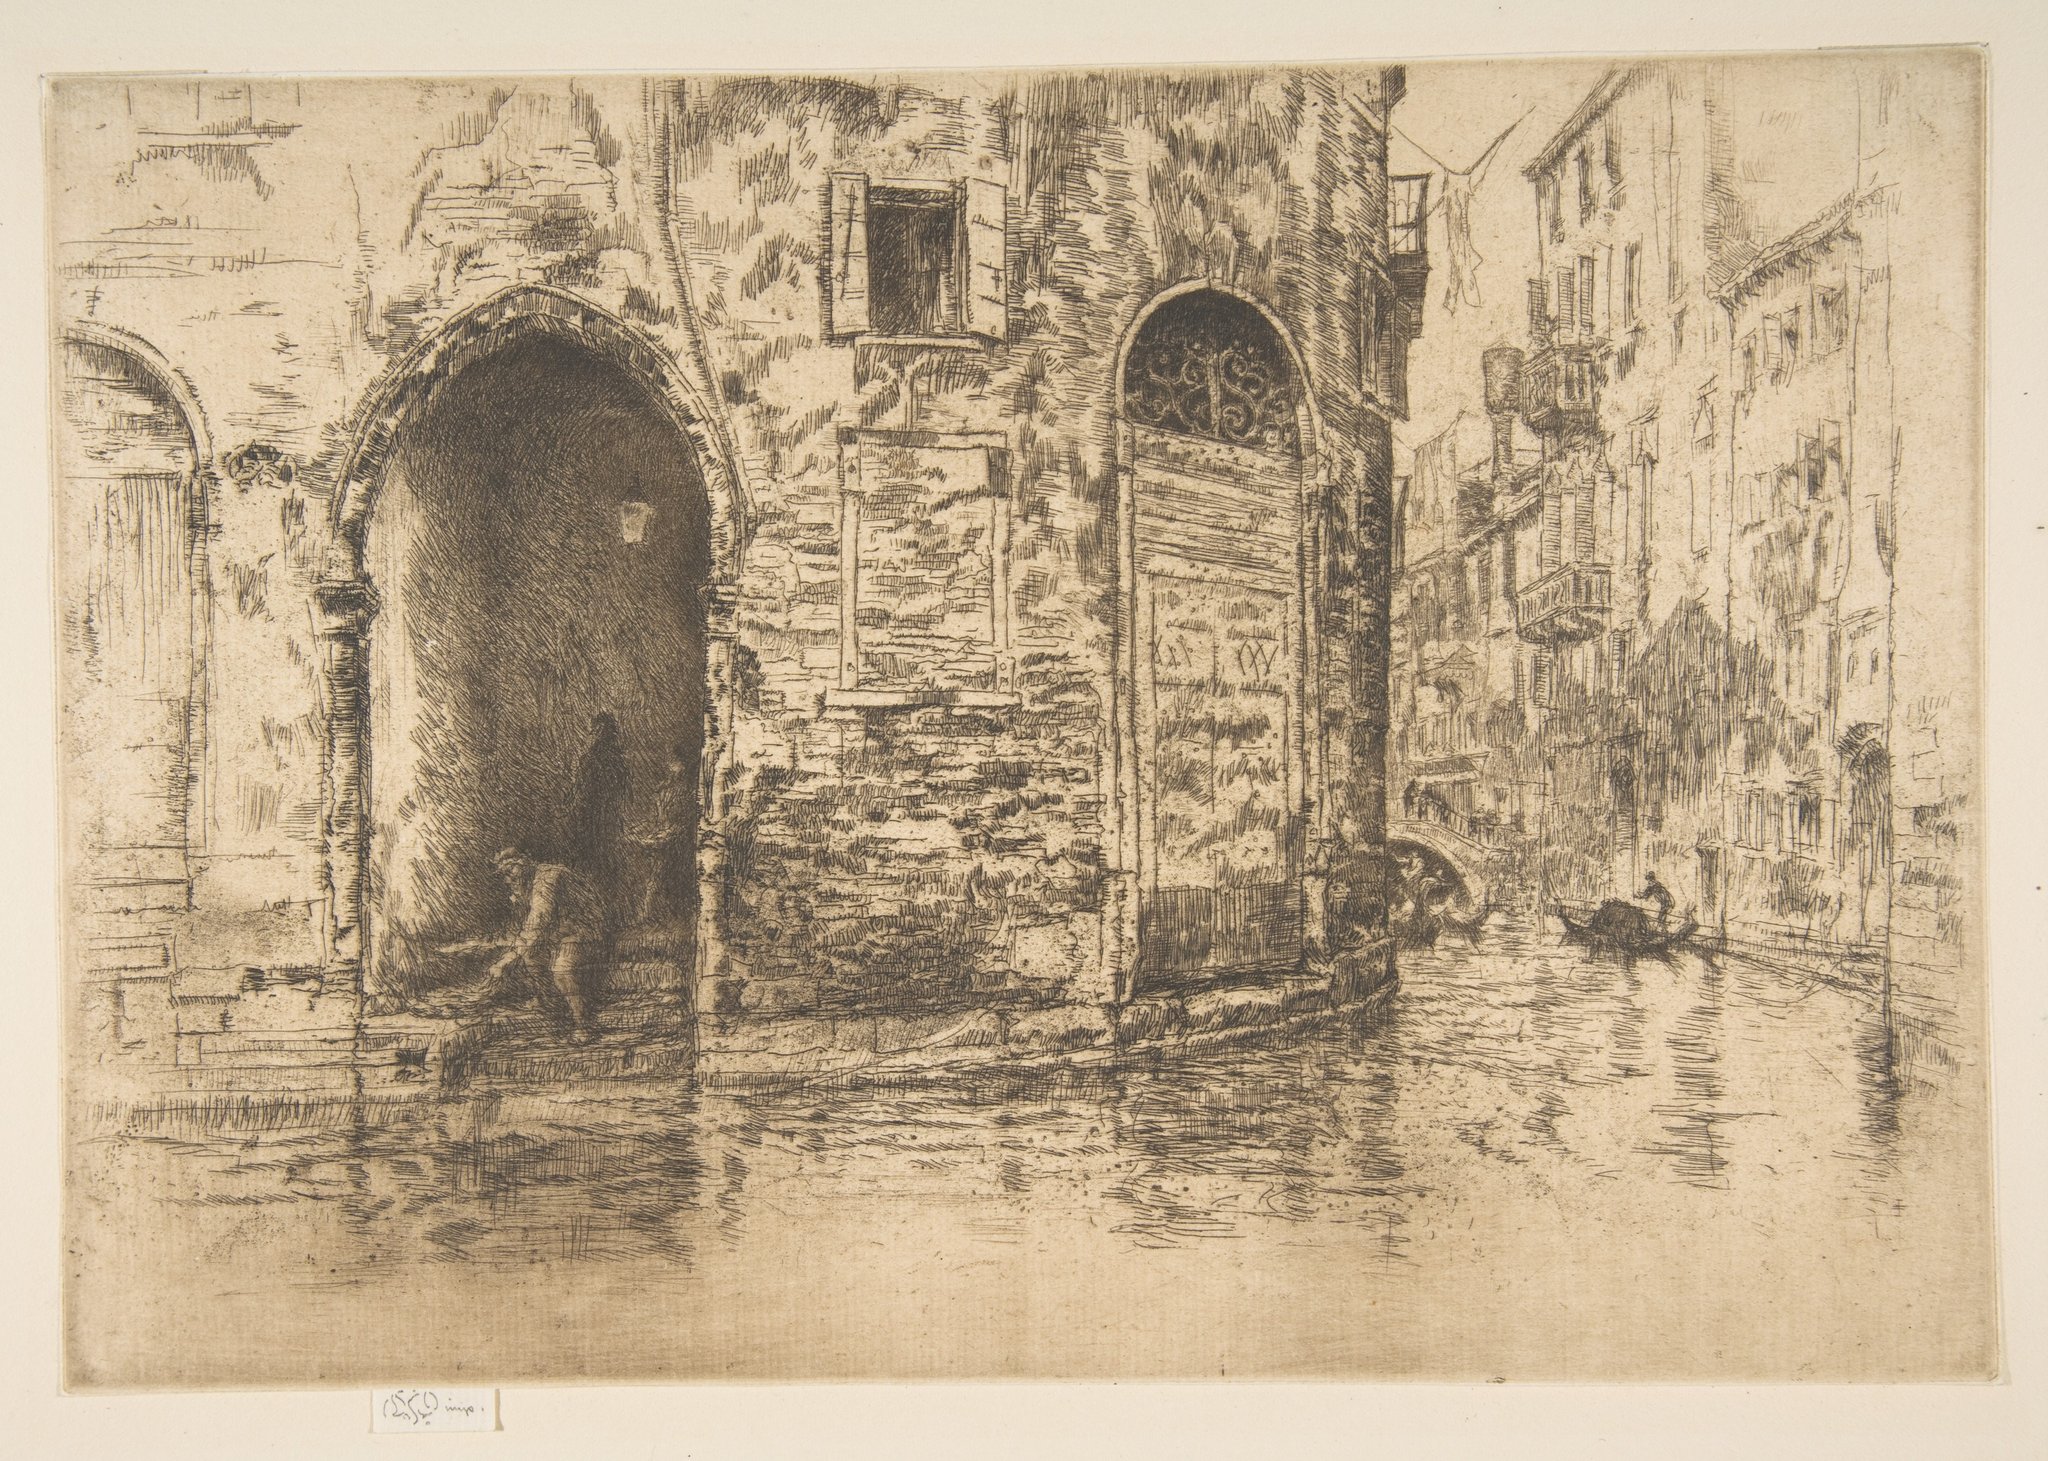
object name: print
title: Two Doorways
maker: james mcneill whistler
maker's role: artist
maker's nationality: american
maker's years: 1834-1903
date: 1879-1880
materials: ink, paper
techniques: drypoint, etching, printing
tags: doorways,canals,boats,venice